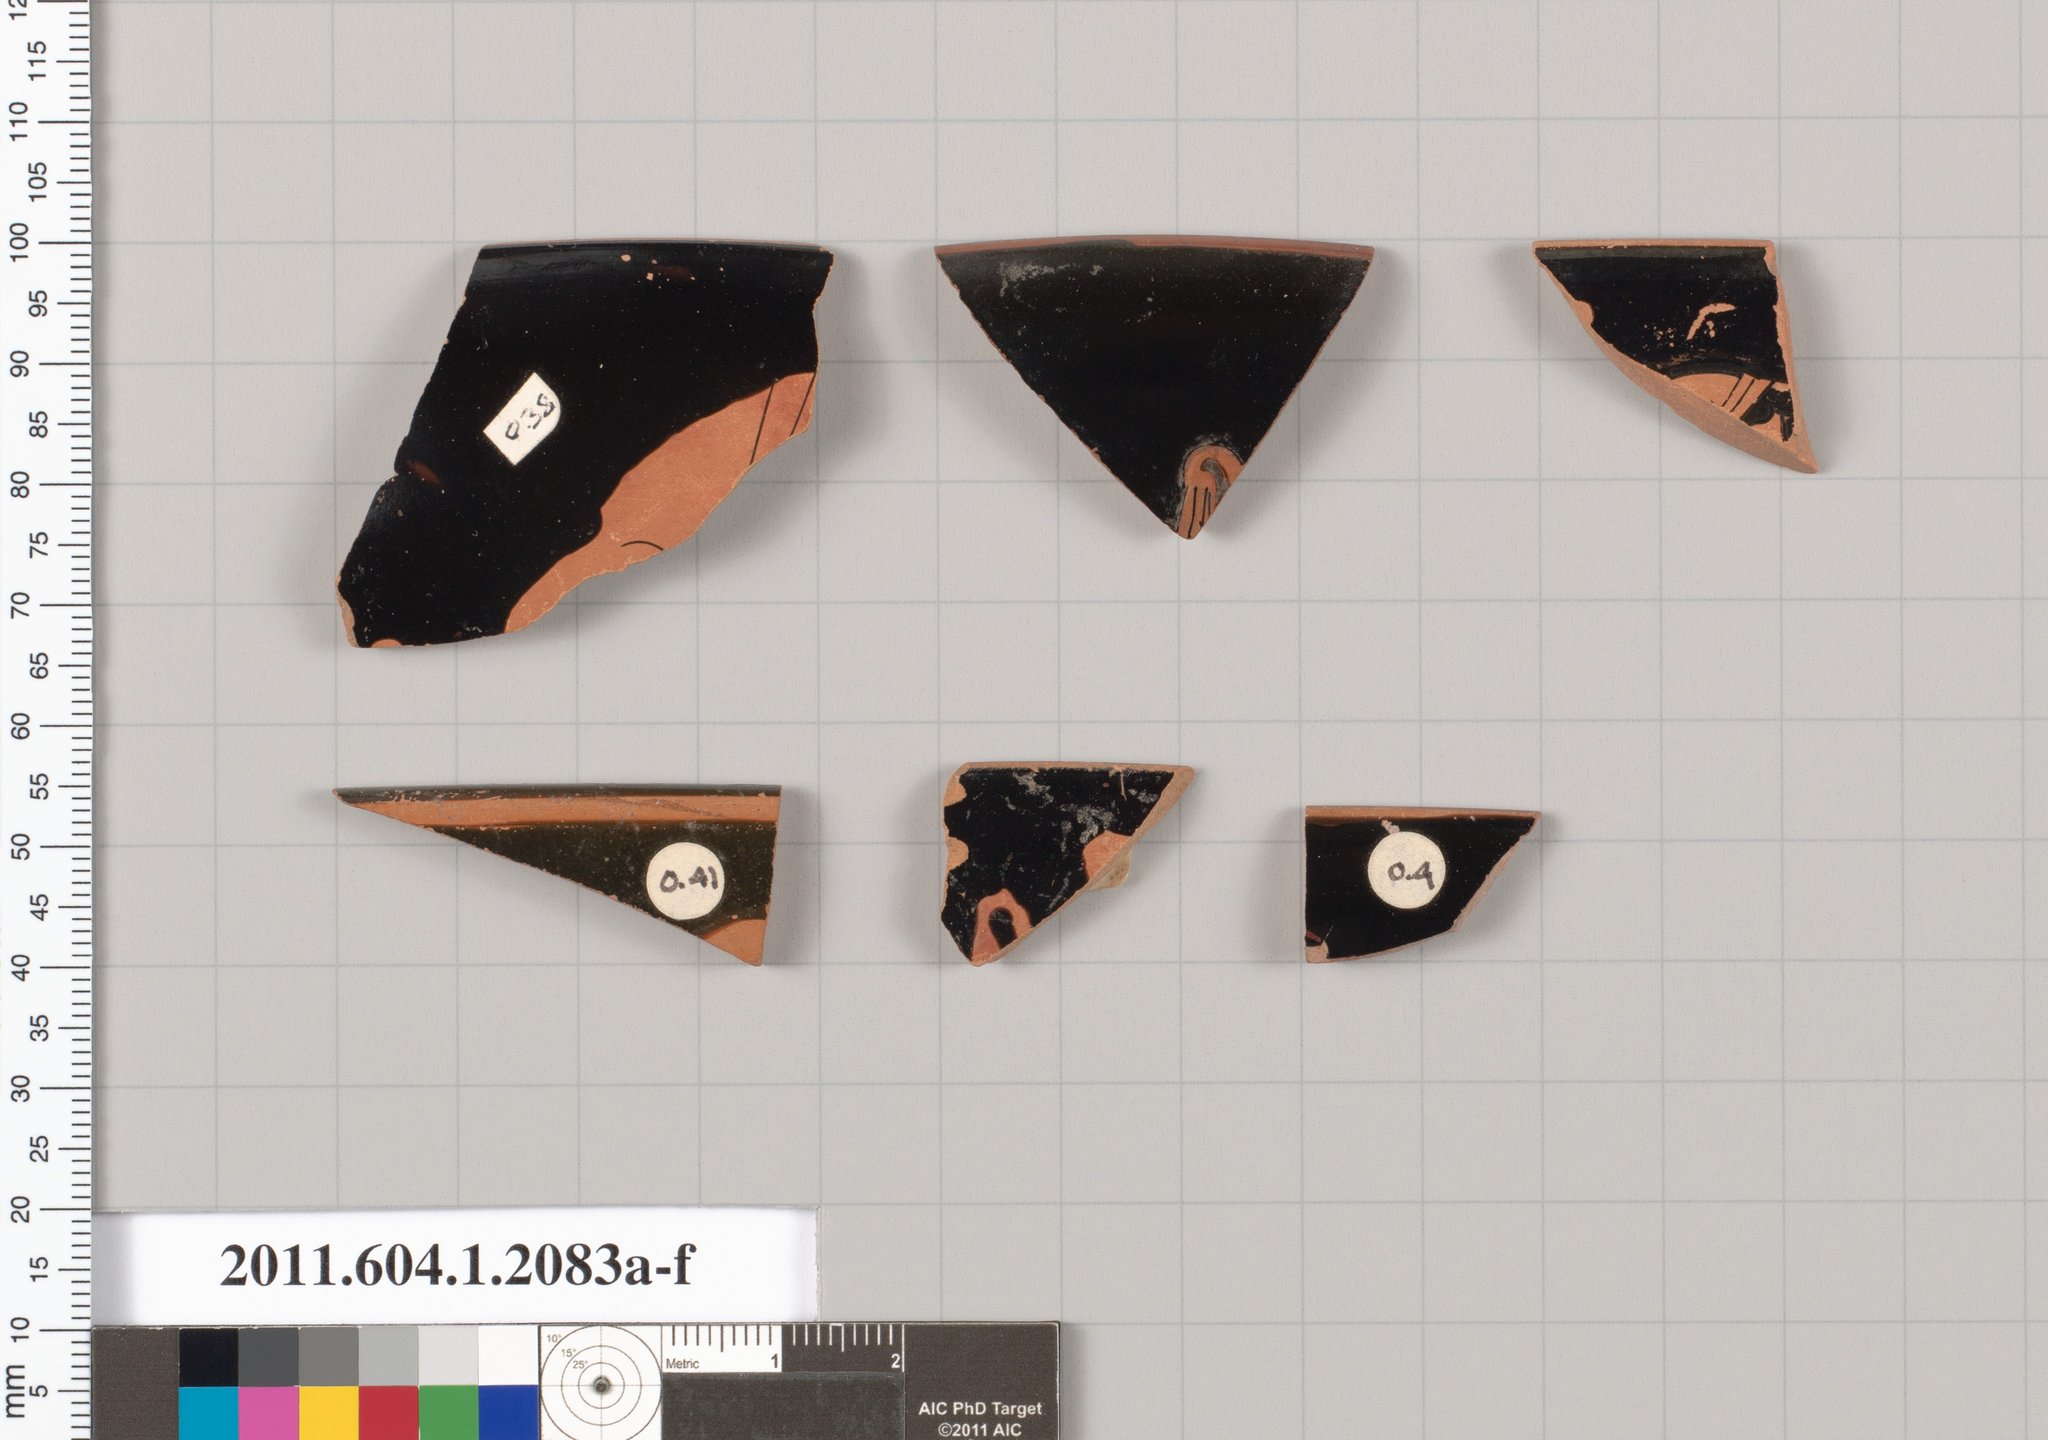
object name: kylix fragment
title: Terracotta rim fragments of kylikes (drinking cups)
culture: greek, attic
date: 500-401 BCE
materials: terracotta